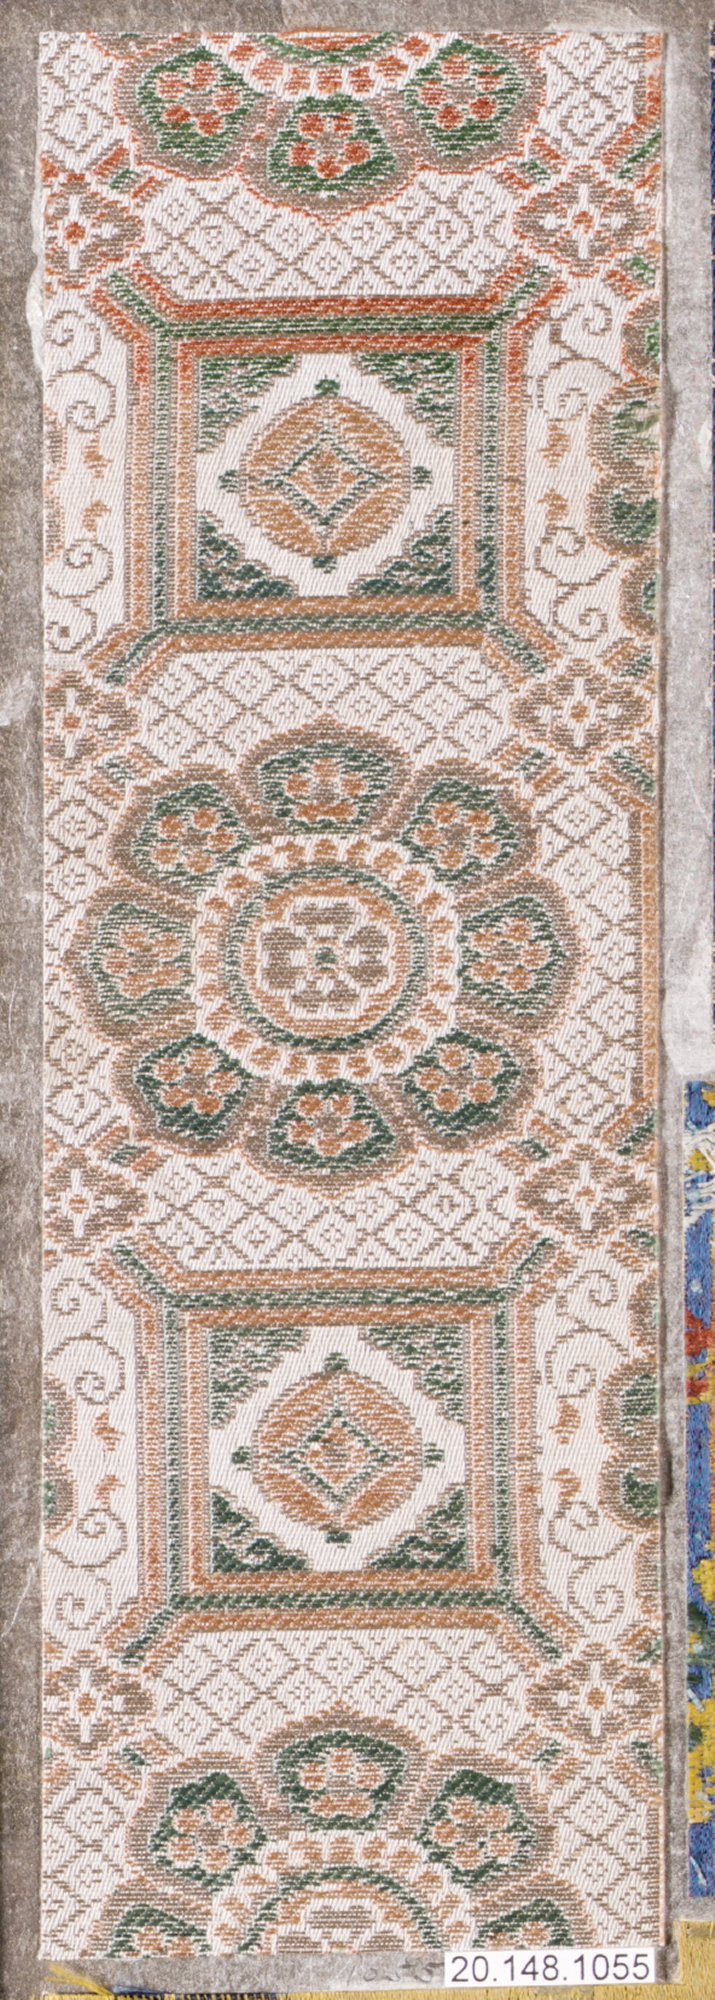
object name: piece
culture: japanese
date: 1701-1800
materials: silk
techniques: compound weave